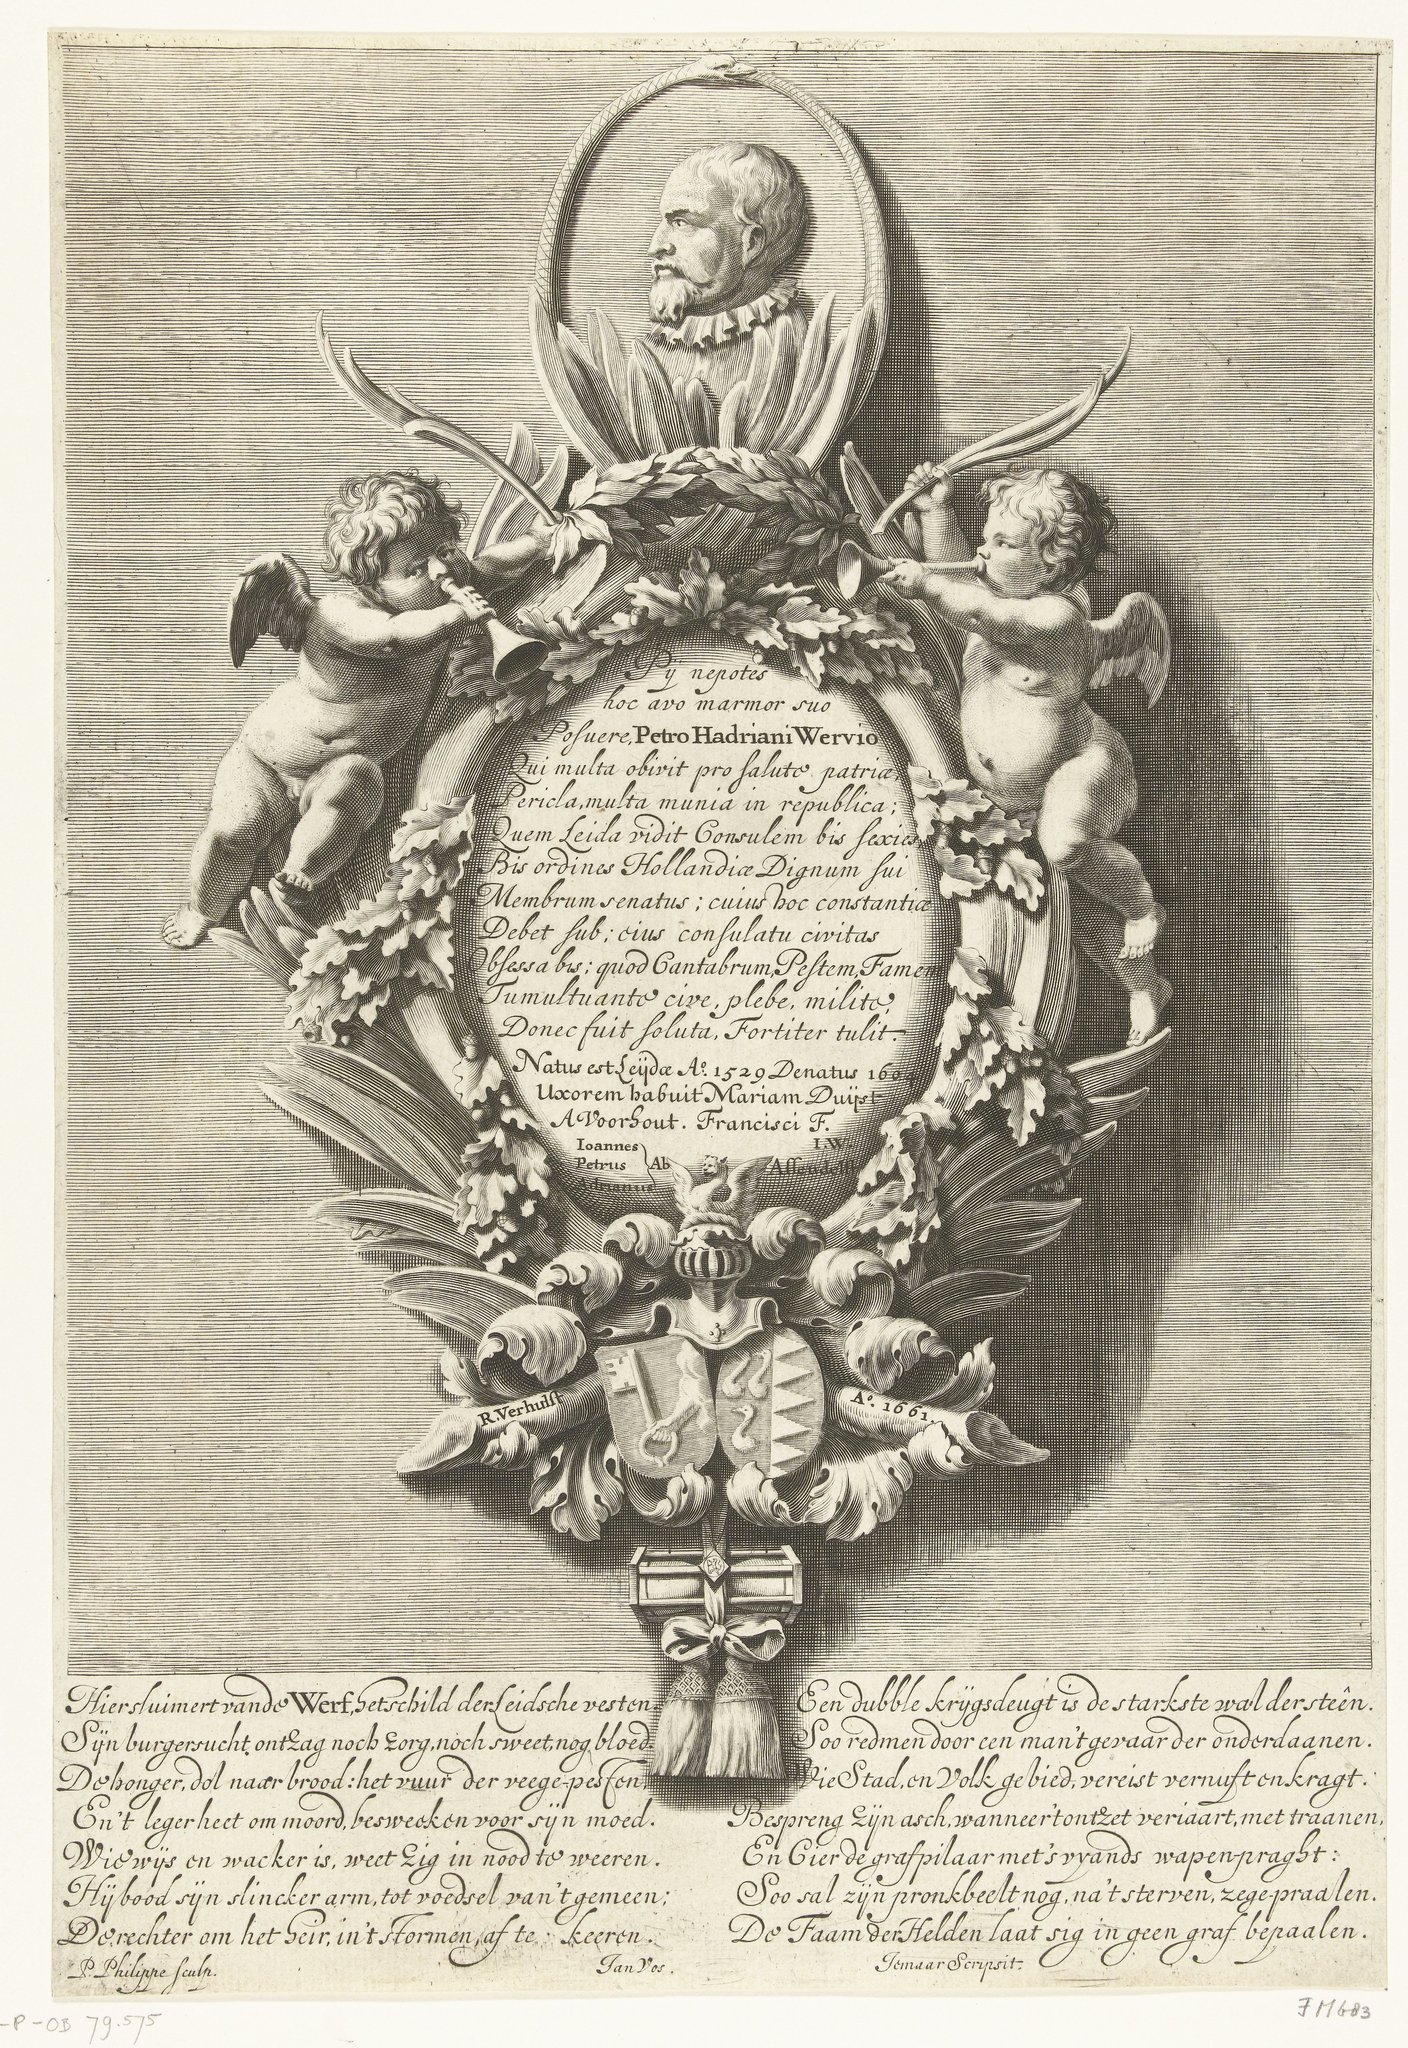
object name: print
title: Grafmonument voor Pieter Adriaansz. van der Werff in de Hooglandse kerk te Leiden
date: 1661-1667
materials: paper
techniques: engraving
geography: northern netherlands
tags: piece of sculpture, reproduction of a piece of sculpture, grave, tomb and other grave-forms and grave-markers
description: Grafmonument voor Pieter Adriaansz. van der Werff, burgemeester van Leiden tijdens het beleg in 1574, in de Hooglandse kerk te Leiden door Rombout Verhulst (1661). Bovenin een portret, in het midden een ovaal met Latijnse tekst in lijst met randwerk met eikenloof en twee putti, onderaan twee wapens en een zandloper. In het onderschrift 2 verzen van elk 7 regels in het Nederlands.